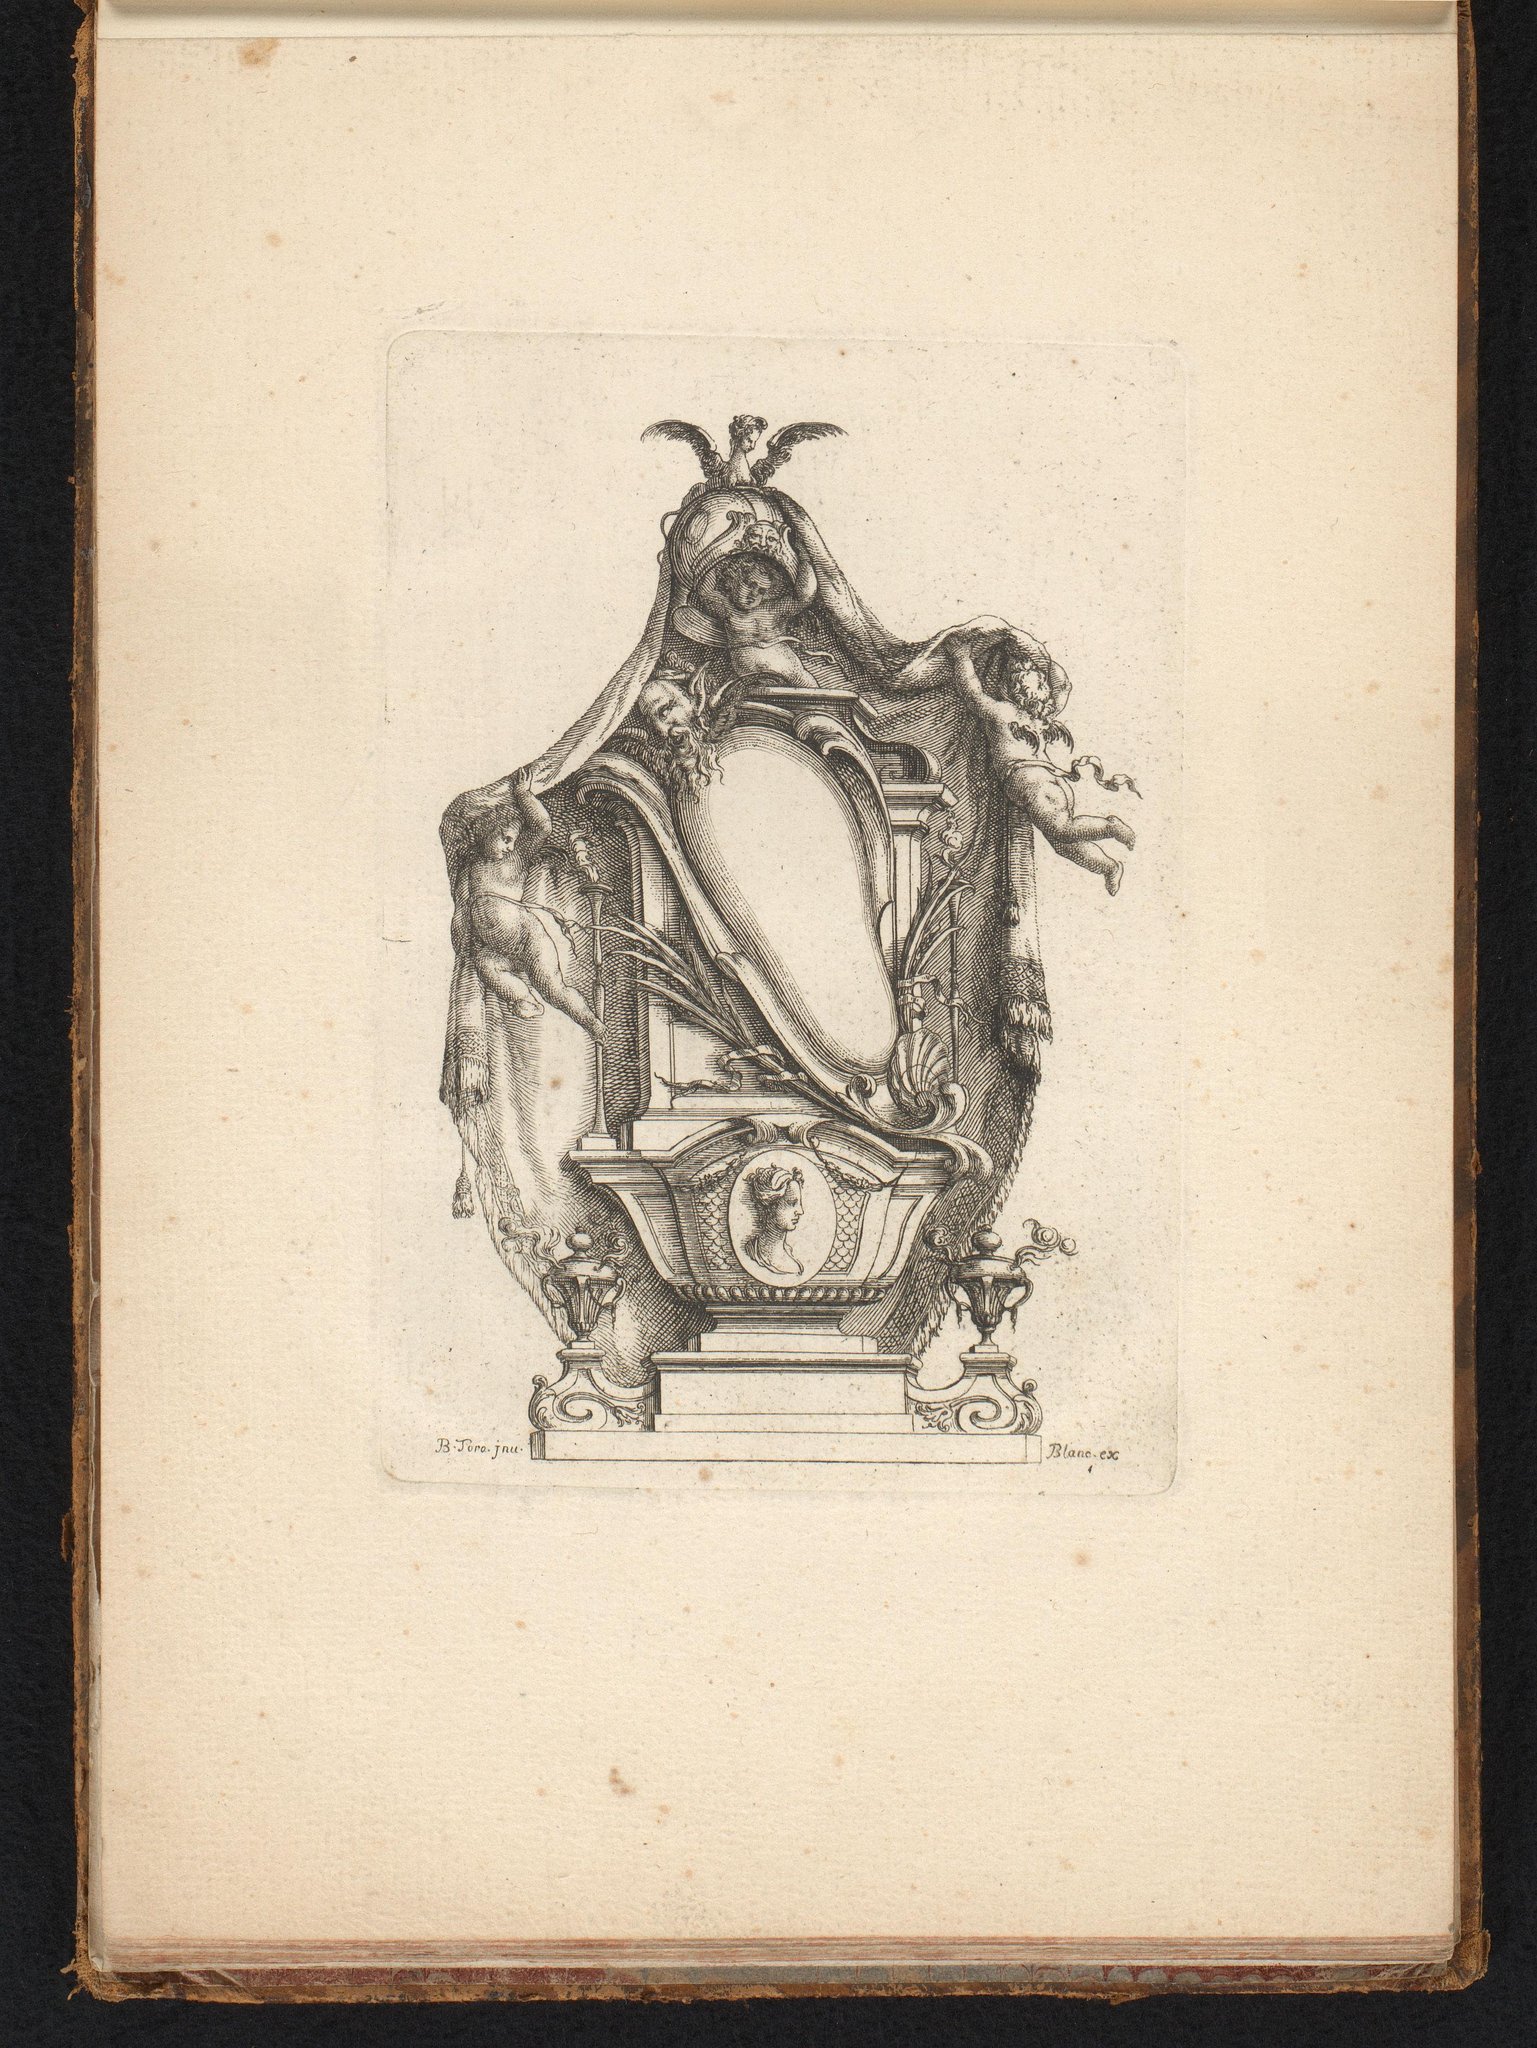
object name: album leaf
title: Ontwerpen voor cartouches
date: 1682-1729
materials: paper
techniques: etching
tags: ornament ~ cartouche, incense-burner ~ scents, perfumes, cupids: 'amores', 'amoretti', 'putti'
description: Prent maakt deel uit van een serie van zes prenten.